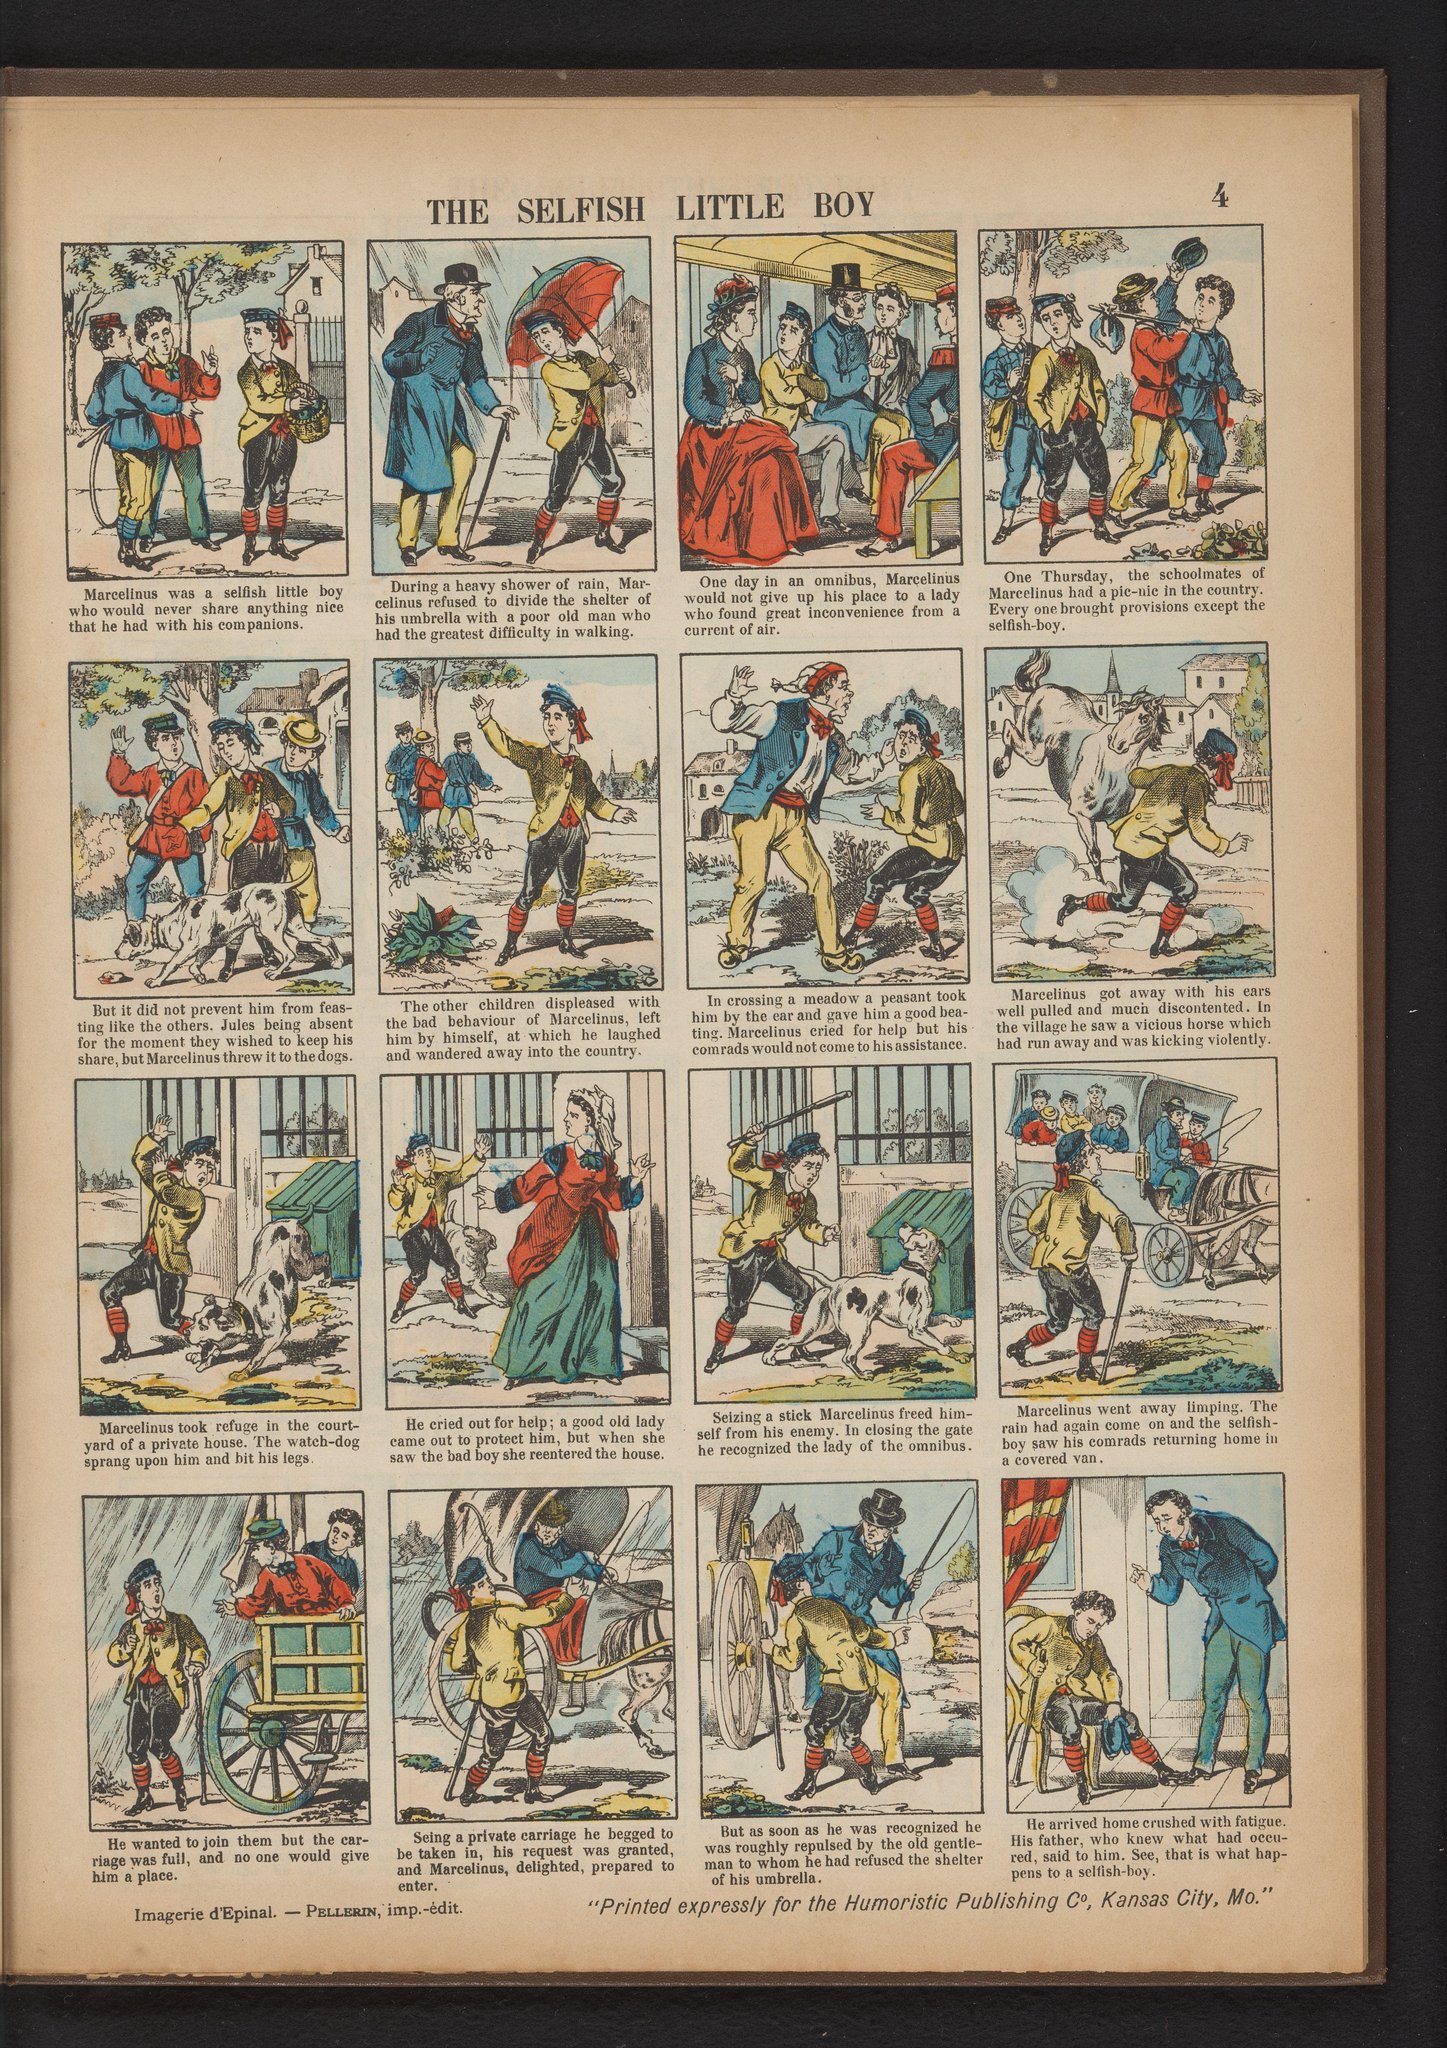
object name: popular print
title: Sprookjes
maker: Anonymous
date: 1893-1894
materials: paper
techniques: colour, letterpress printing, lithograph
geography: epinal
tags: selfishness; 'interesse', 'interesse proprio' (ripa)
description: Blad met zestien voorstellingen over de egoïstische jongen Marcelinus. Onder elke voorstelling een onderschrift in het Engels. Deze prent maakt deel uit van een album.